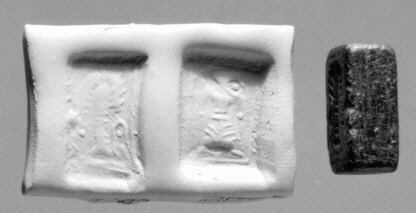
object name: stamp cylinder seal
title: Stamp-cylinder seal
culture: cypriot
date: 1200-1101 BCE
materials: marble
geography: cyprus